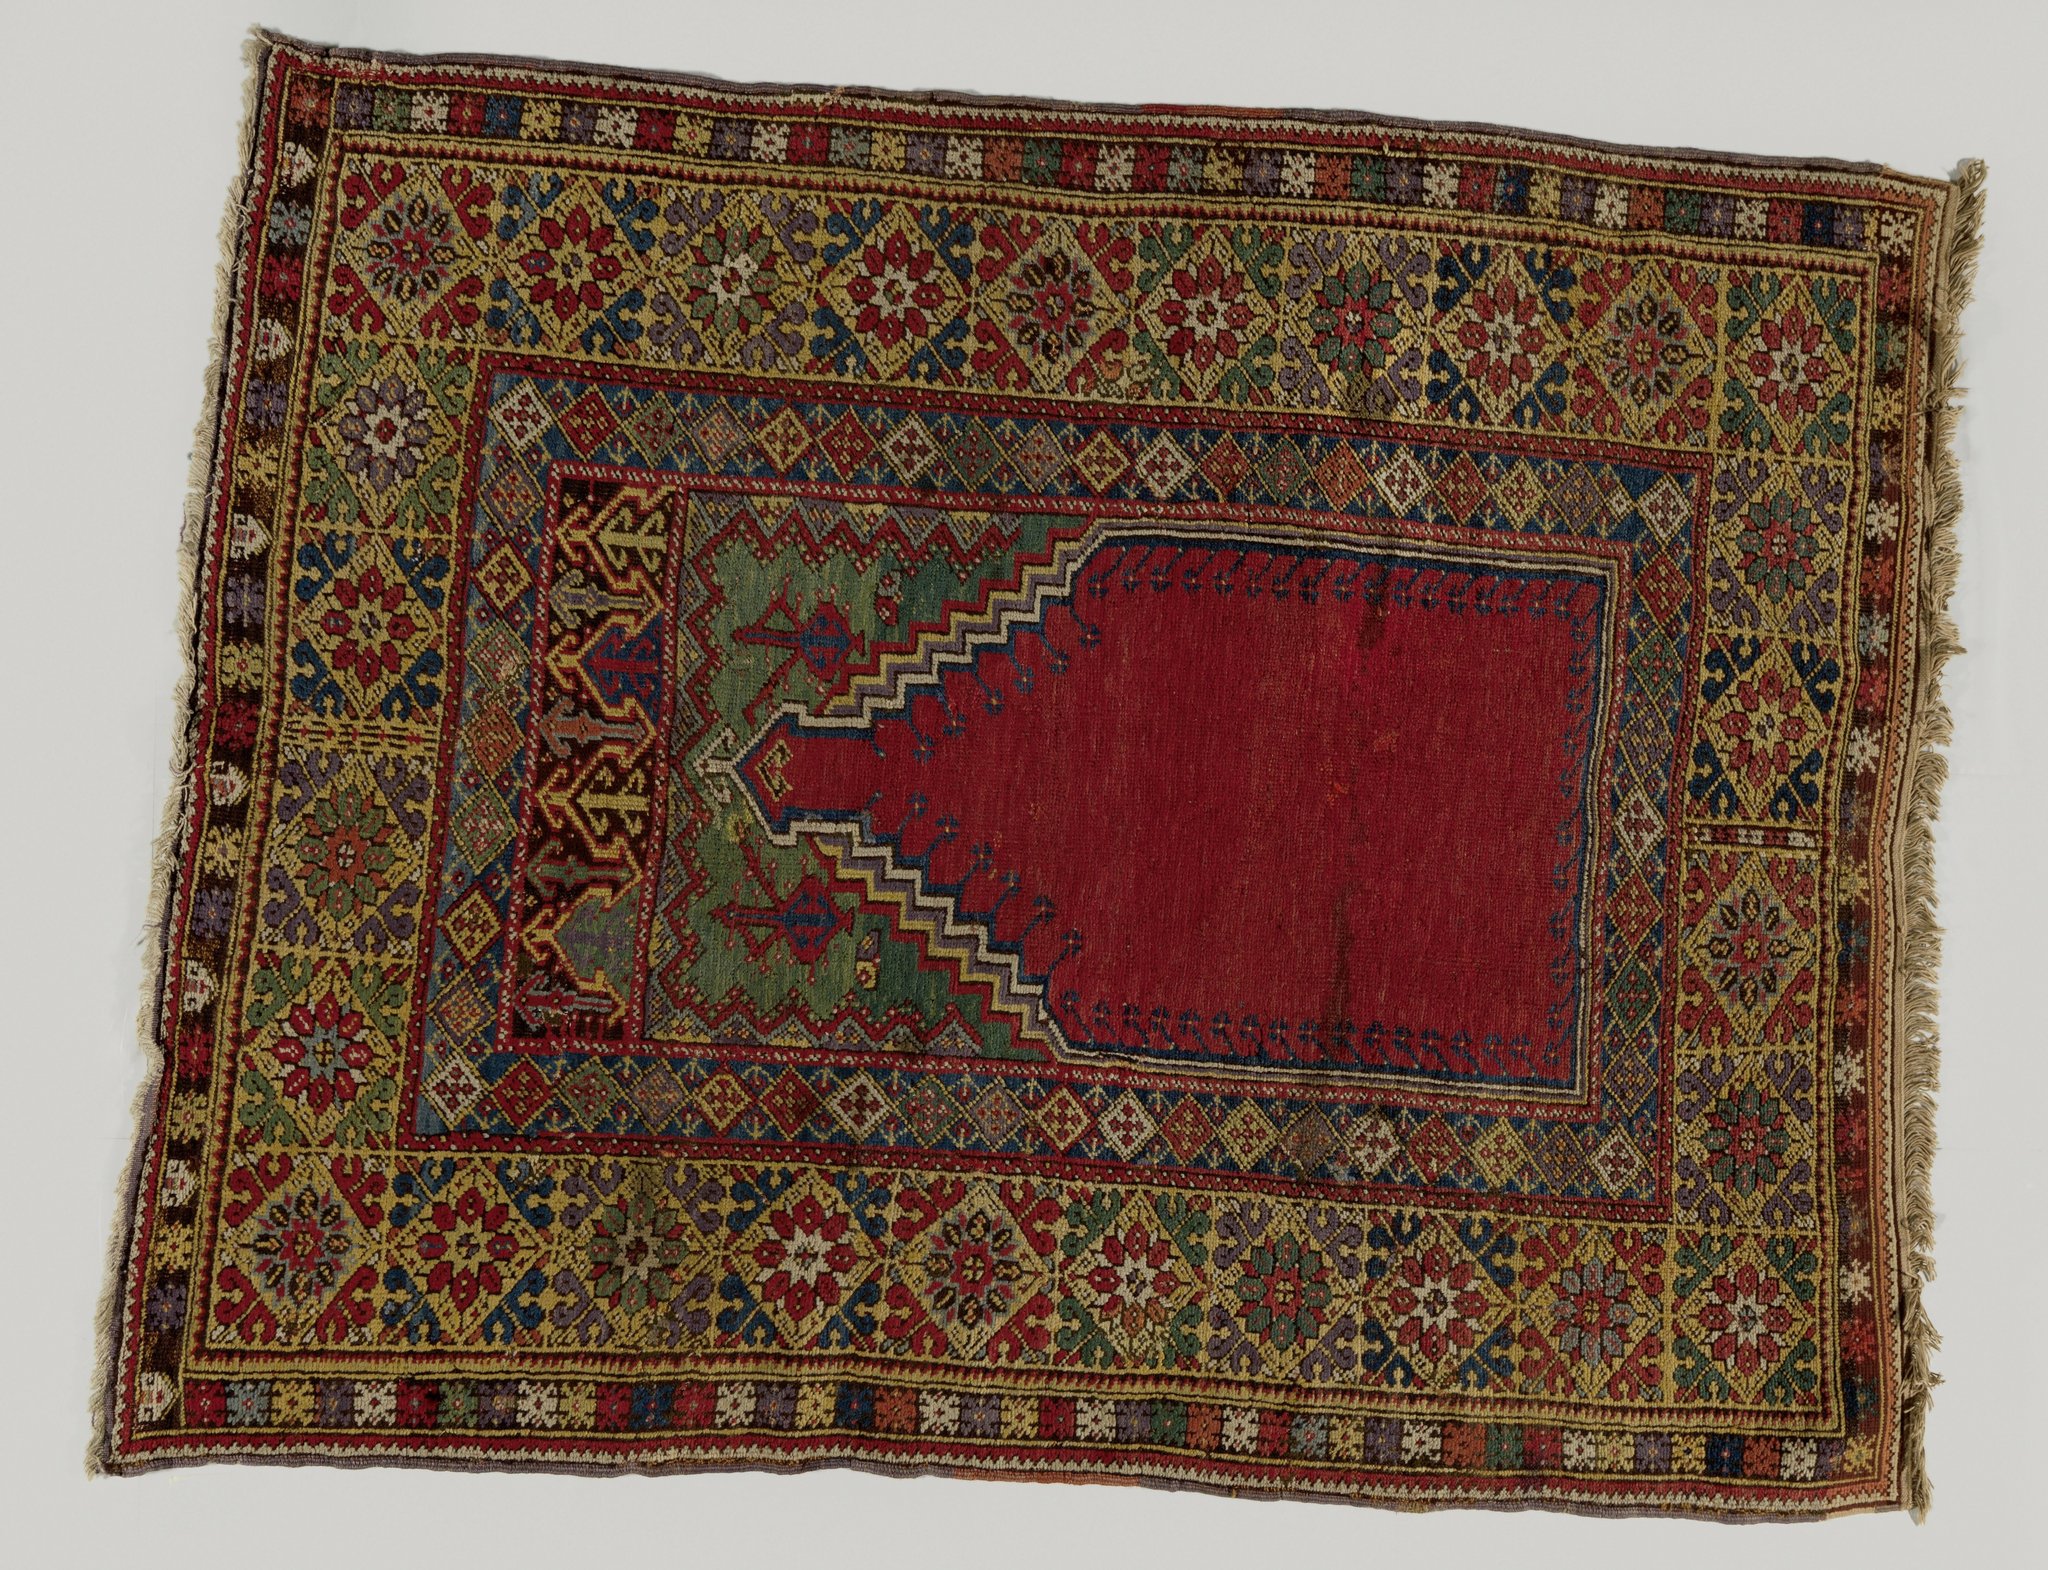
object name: oriental rug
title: Bidkleed met bovenpaneel, MUDJUR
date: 1840-1860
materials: wool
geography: mudjur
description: Bidkleed met bovenpaneel, MUDJUR. Middenveld: kersrode mihrab met hoge topgevel met vijfkleurige trapgevellijnen. De zwikken zijn grijsgroen met twee rode oliekannen. Een smal fries vertoont een gele "omegalijn" die het paneel verdeelt in blauwe en zwarte kantelen. Randn: veelvoudig. De breedste is geel met uitgespaarde zuivere vierkanten, gevuld met een sterbloem en los daarvan staande overhoekse bladeren in vele kleuren, fijn kaleidoscopisch onderverdeeld. De binnenzoom in blauw met ruiten is gevat in twee gelijke gespikkelde biezen. De buitenzoom is zwart.